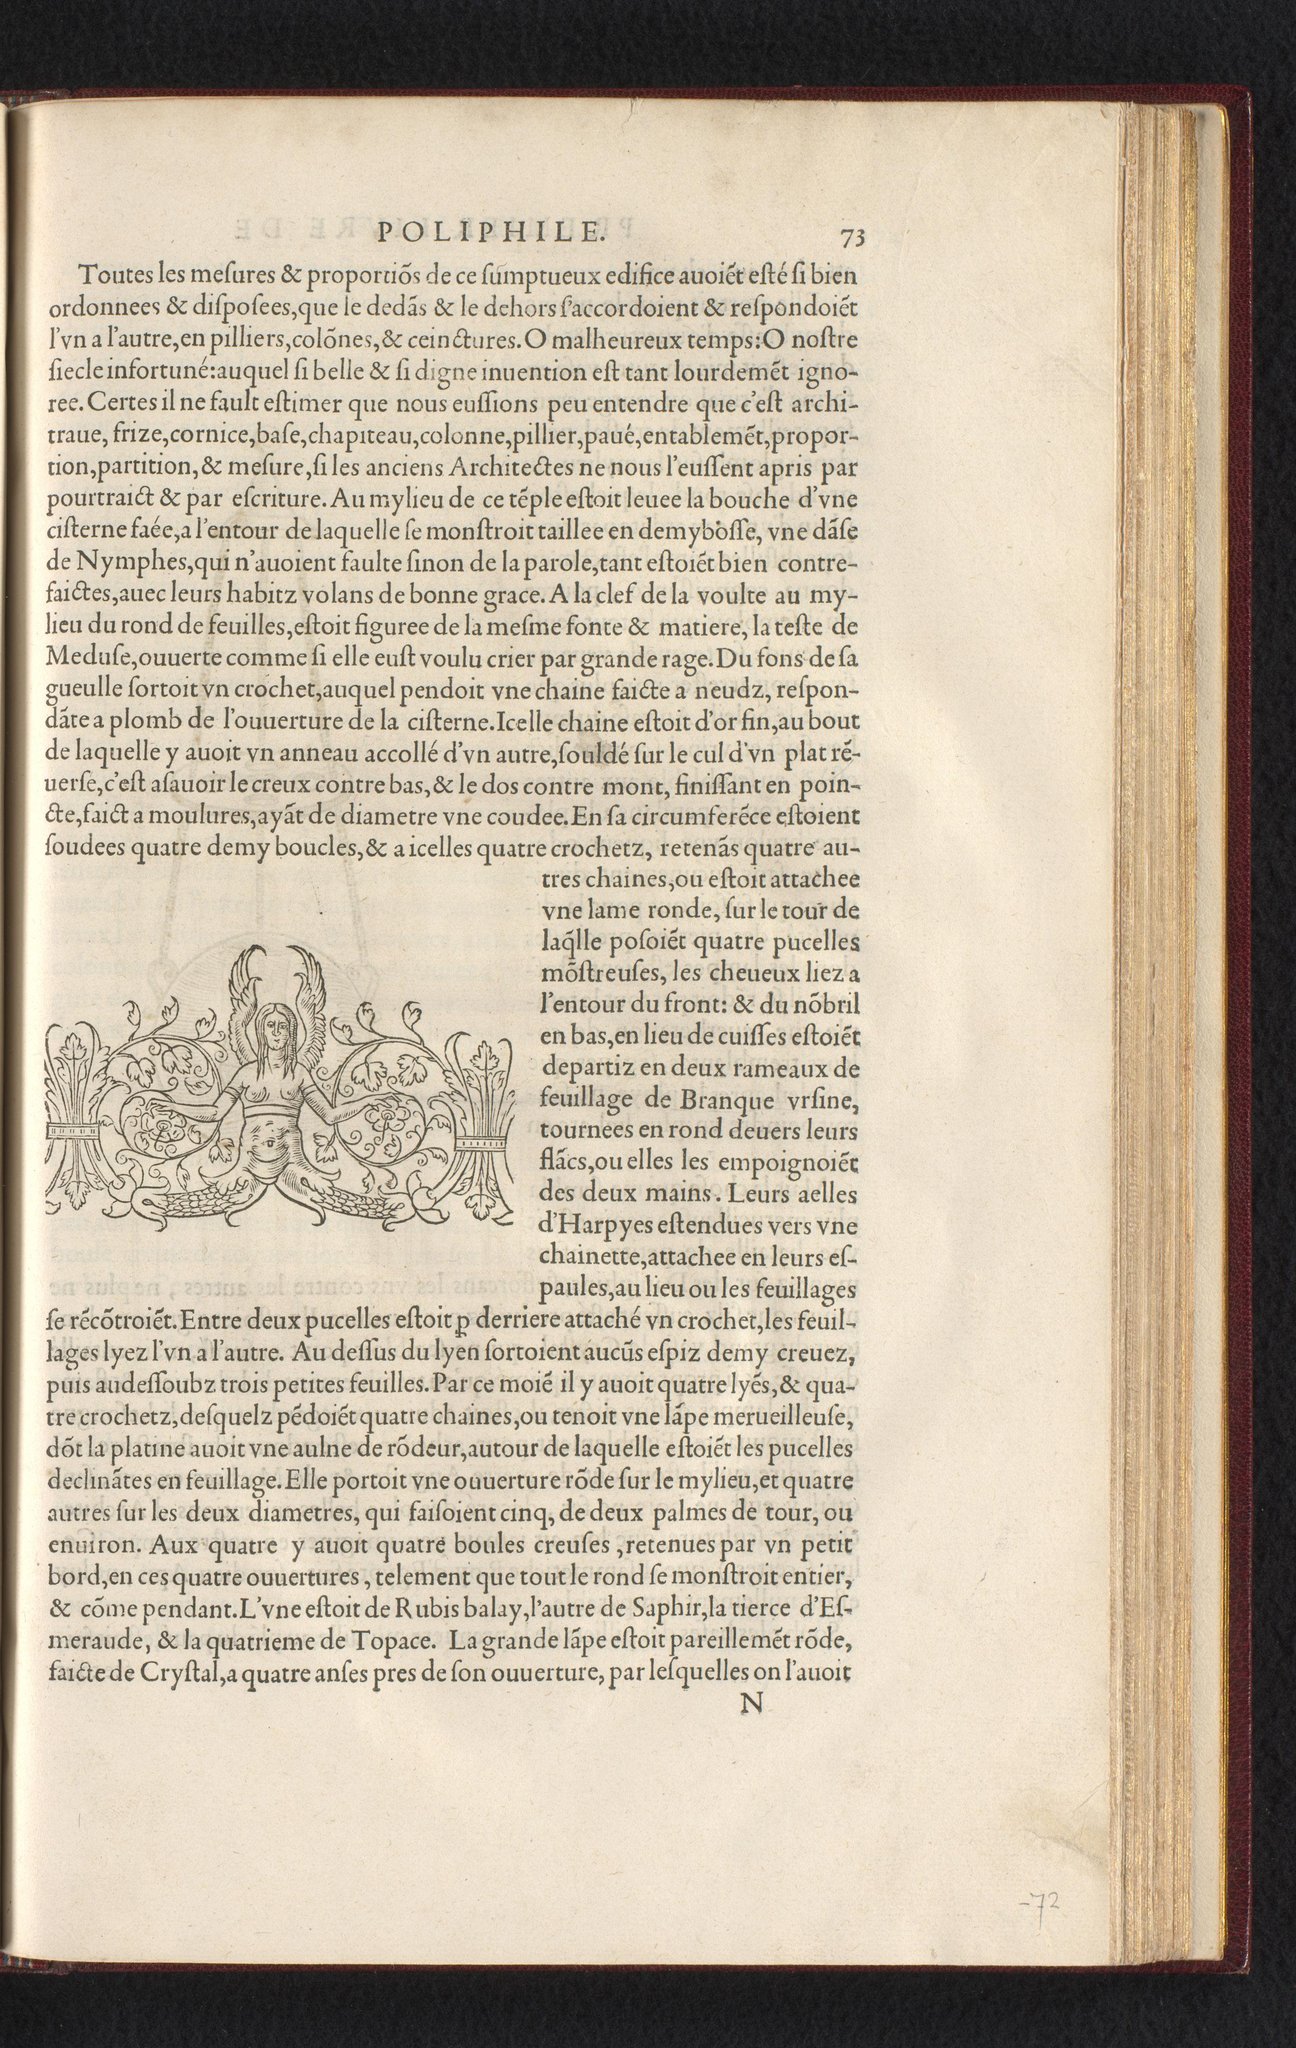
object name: print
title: Ornament met een gevleugelde vrouwenfiguur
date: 1546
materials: paper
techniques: letterpress printing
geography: paris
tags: ornament ~ hybrid beings; human and animal forms mixed, (scenes from) specific works of literature: colonna, hypnerotomachia poliphili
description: Prent uit: Colonna, Francesco. Hypnerotomachie ou discours du songe de Poliphile, deduisant comme amour le combat a l'occasion de Polia. Parijs: Jacques Kerver, 1546, recto fol. 73.